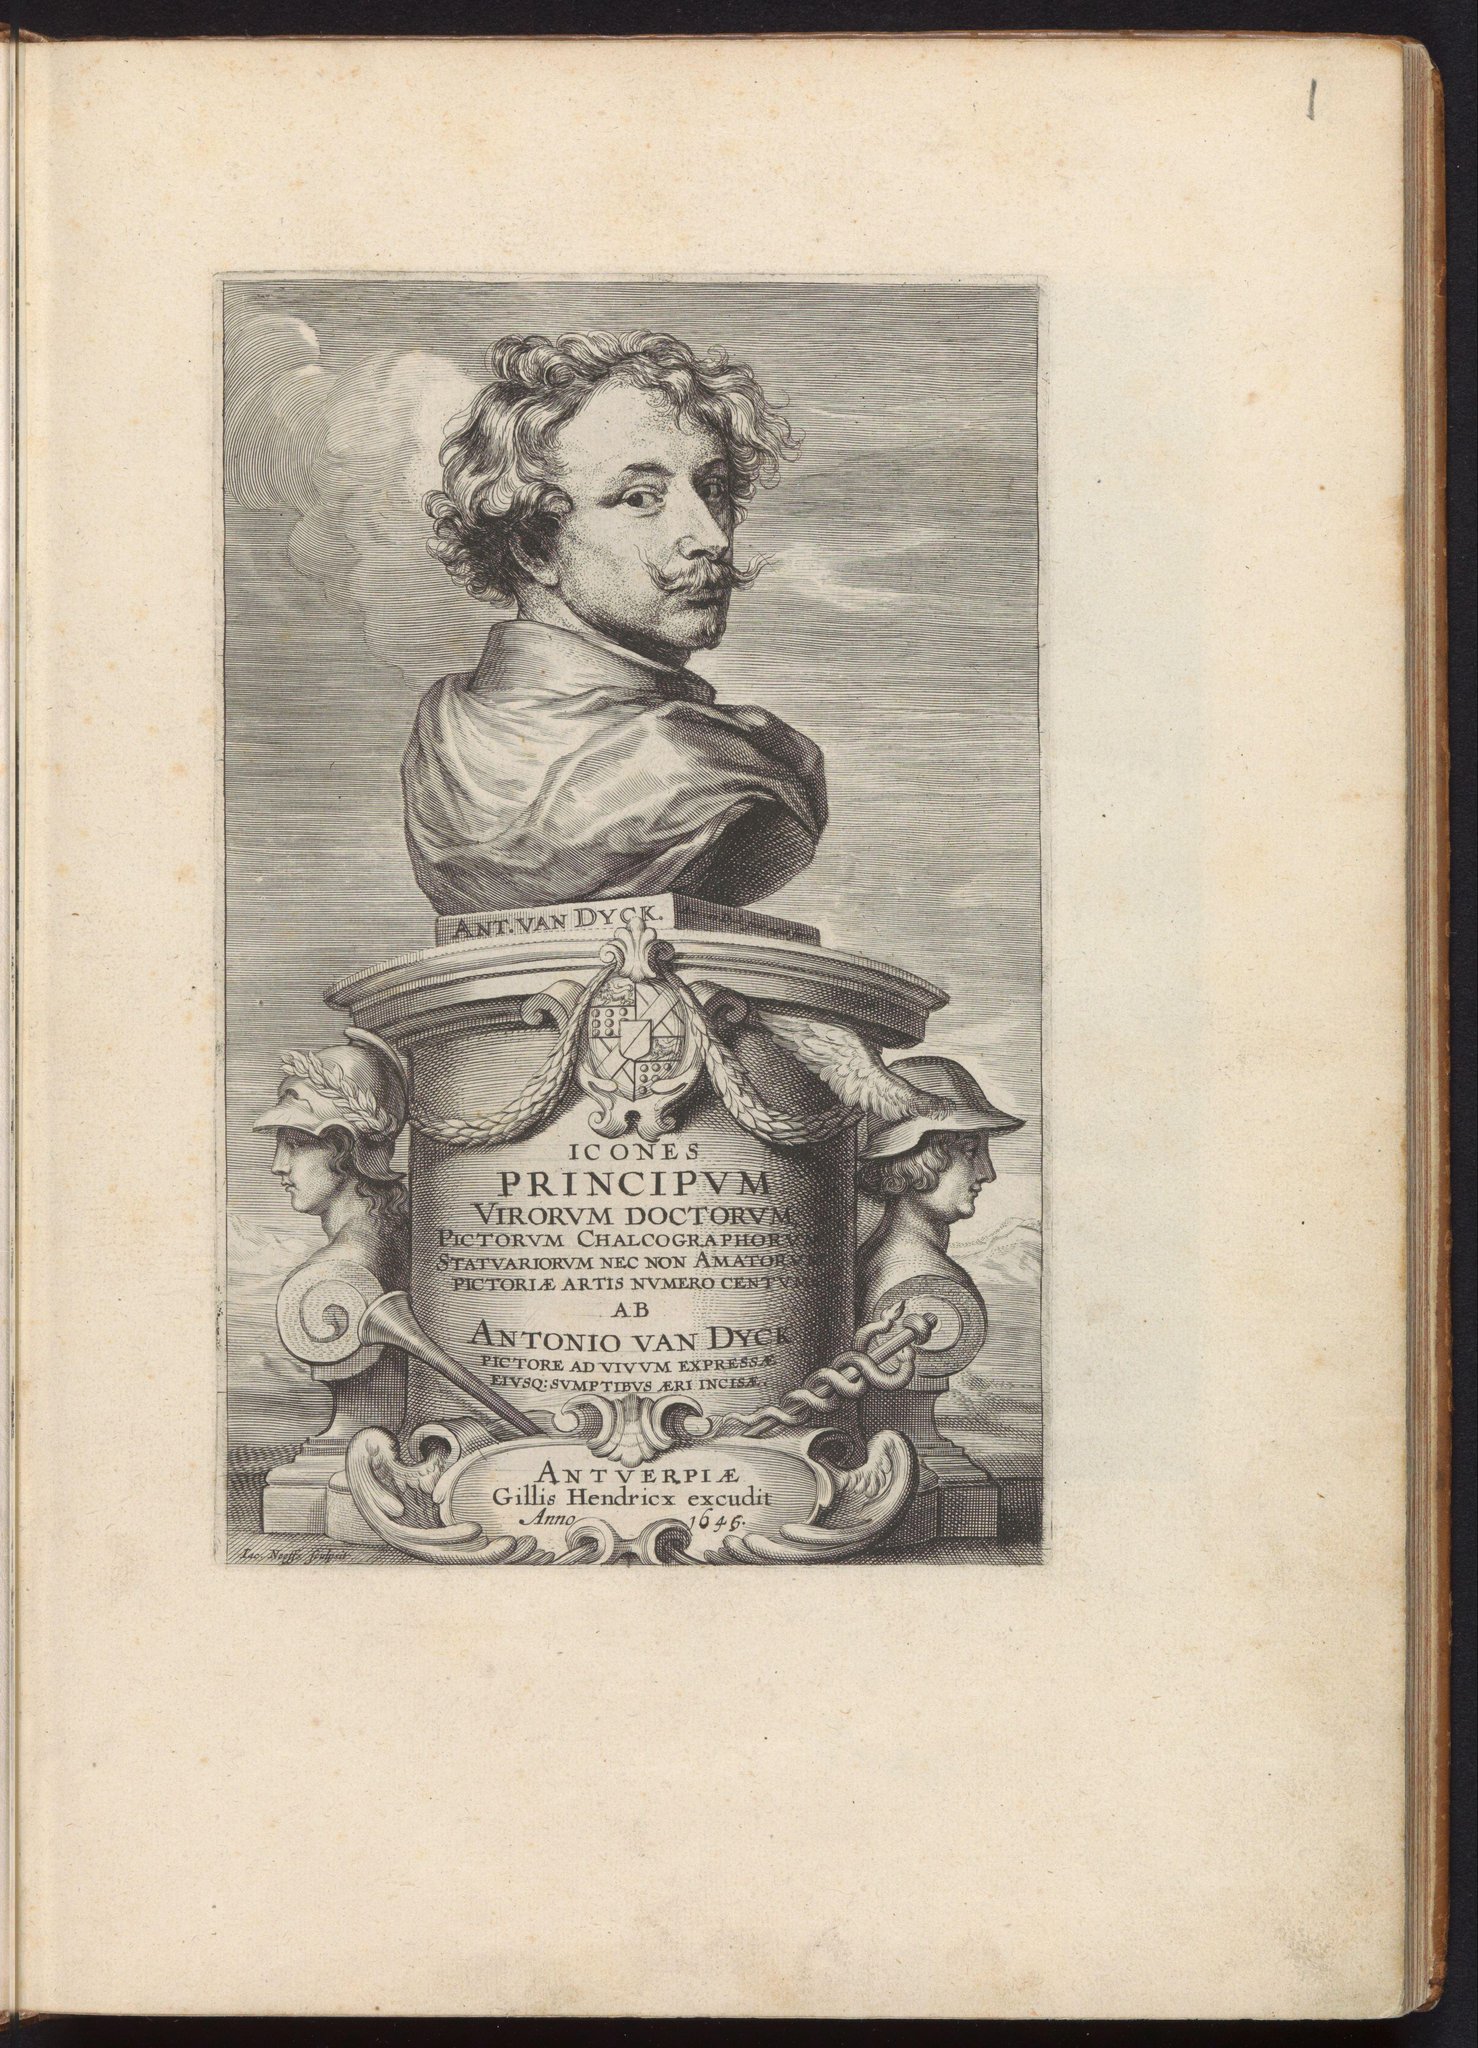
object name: titelprent, frontispice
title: Iconographie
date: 1630-1632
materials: paper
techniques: engraving, etching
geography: antwerp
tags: antwerp, london, painter, print maker, draughtsman, anthony van dyck, (story of) minerva (pallas, athena), (story of) mercury (hermes), portrait, self-portrait of painter, piece of sculpture, reproduction of a piece of sculpture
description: Zelfportret van kunstenaar Anthony van Dyck. De buste is geplaatst op een sokkel. Links de beeltenis van Minerva, rechts de beeltenis van Mercurius. Midden onder een cartouche met hoorn en caduceus, de staf van Mercurius. Deze prent maakt deel uit van een album.